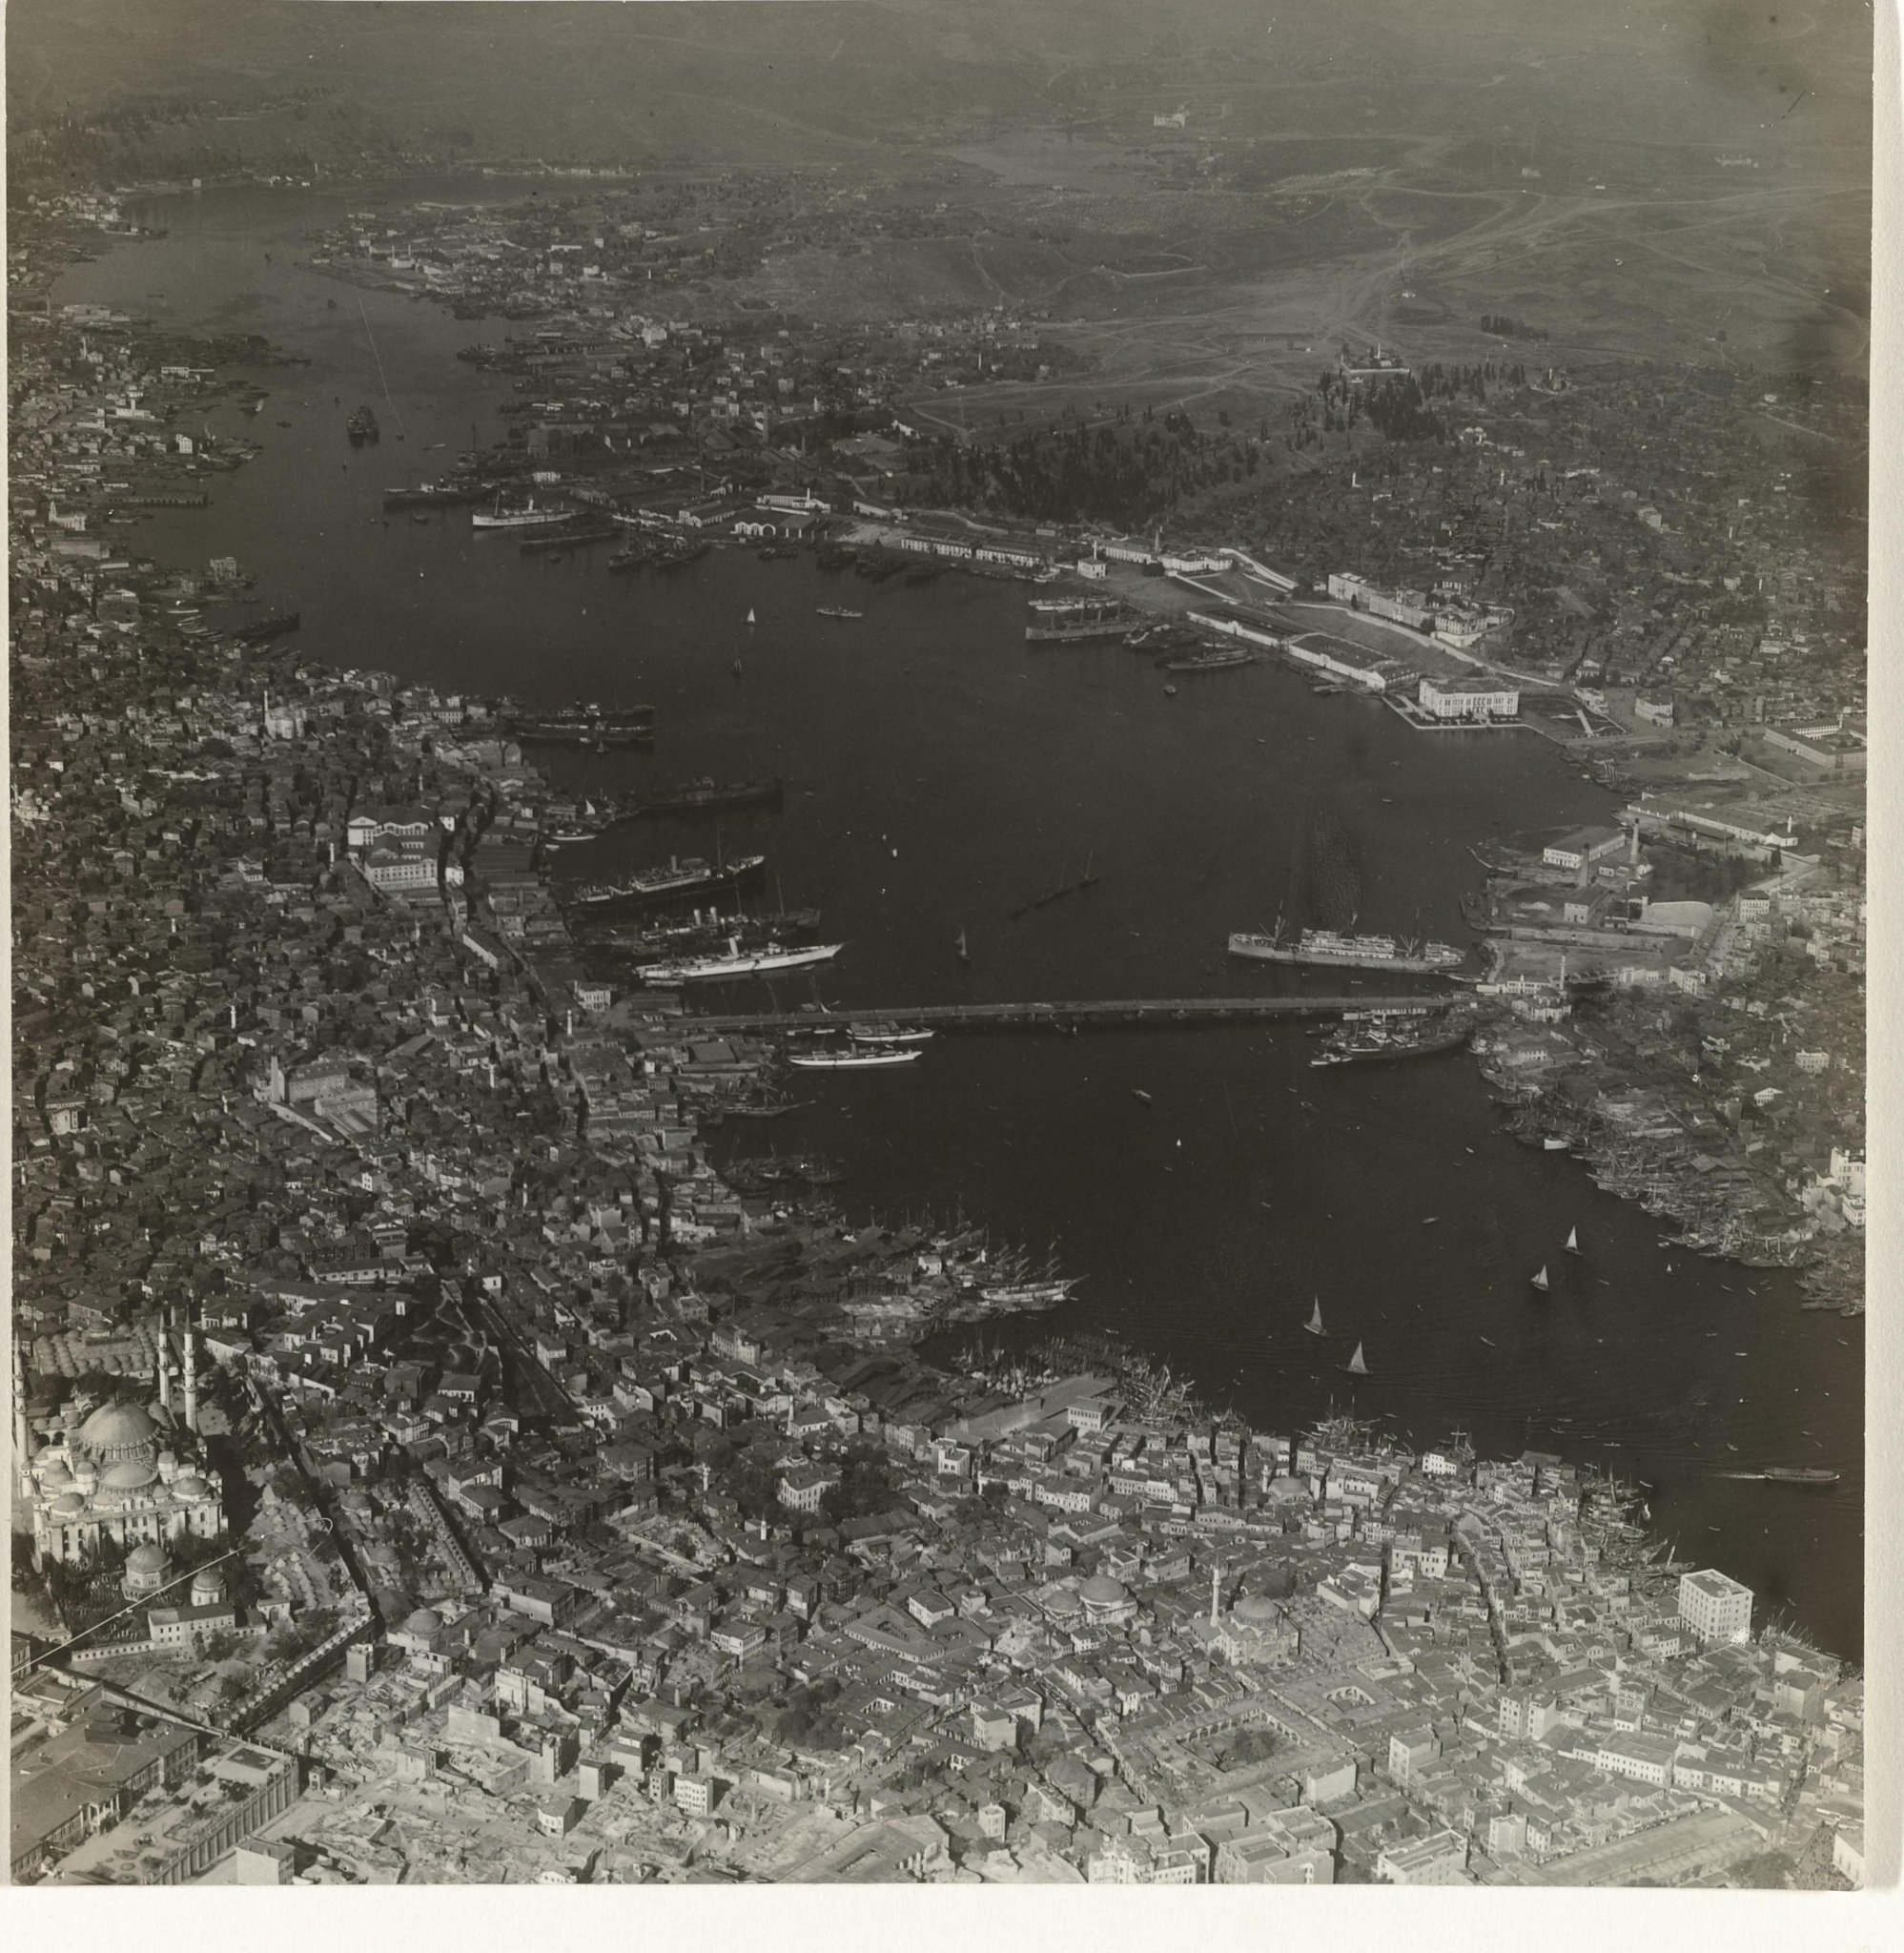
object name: photograph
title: Luchtfoto van Istanbul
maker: Anonymous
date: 1930-1975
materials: photographic support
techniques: gelatin silver print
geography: istanbul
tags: istanboel